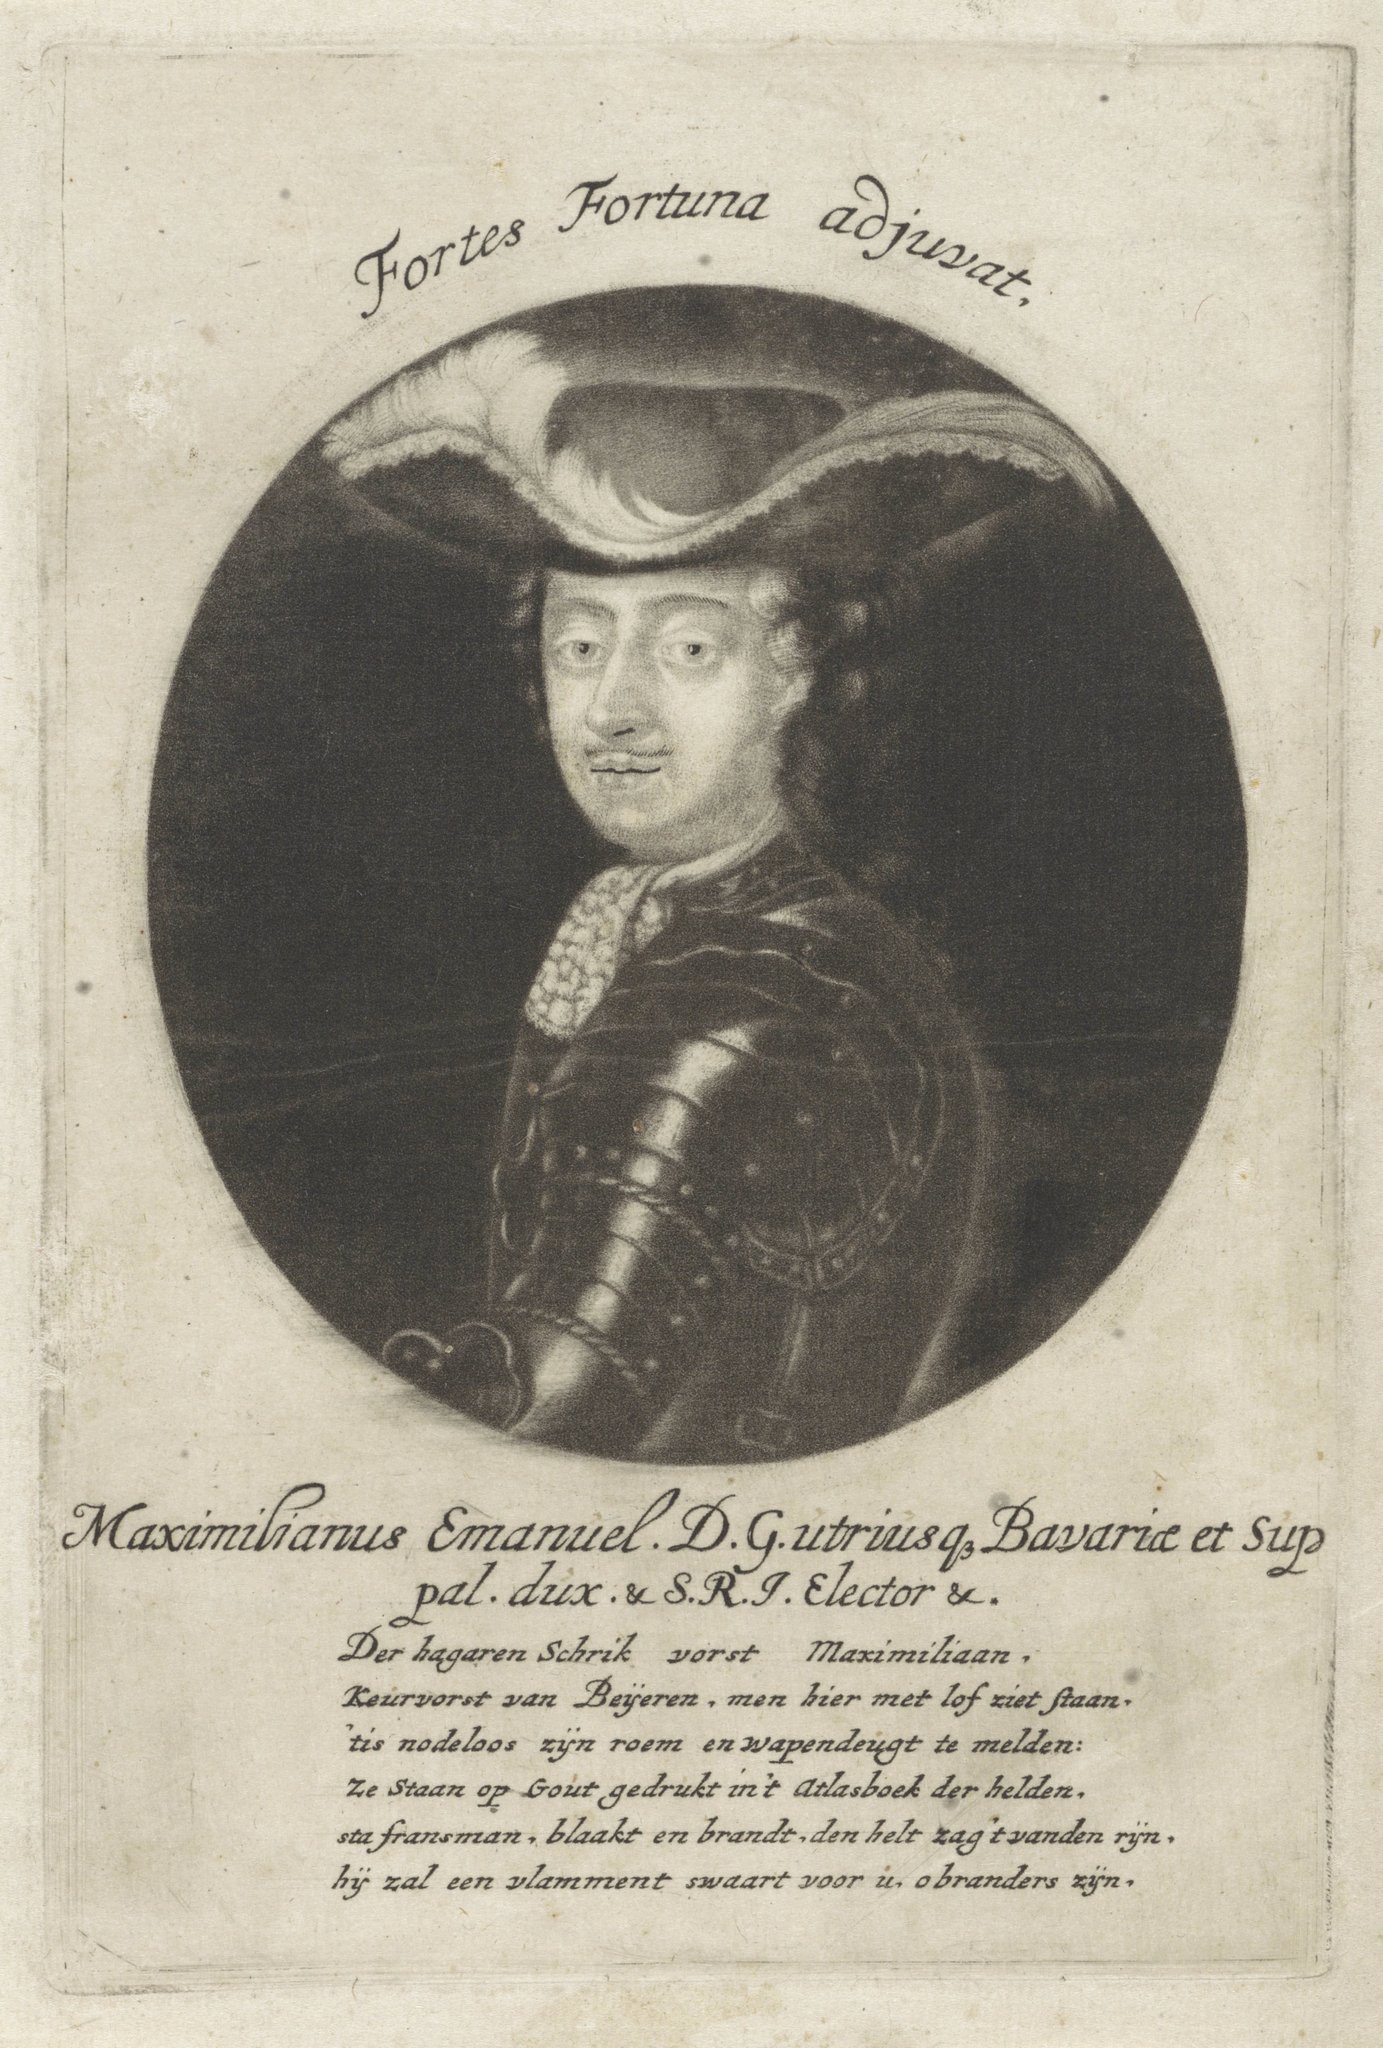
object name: print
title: Portret van Maximiliaan Emanuel II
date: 1692-1763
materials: paper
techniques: engraving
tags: maximiliaan ii emanuel (keurvorst van beieren), armour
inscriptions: collector's mark: Lugt 2228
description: Maximiliaan Emanuel II, keurvorst van Beieren en landvoogd van de Zuidelijke Nederlanden. Hij draagt een harnas en een kraag van kant.